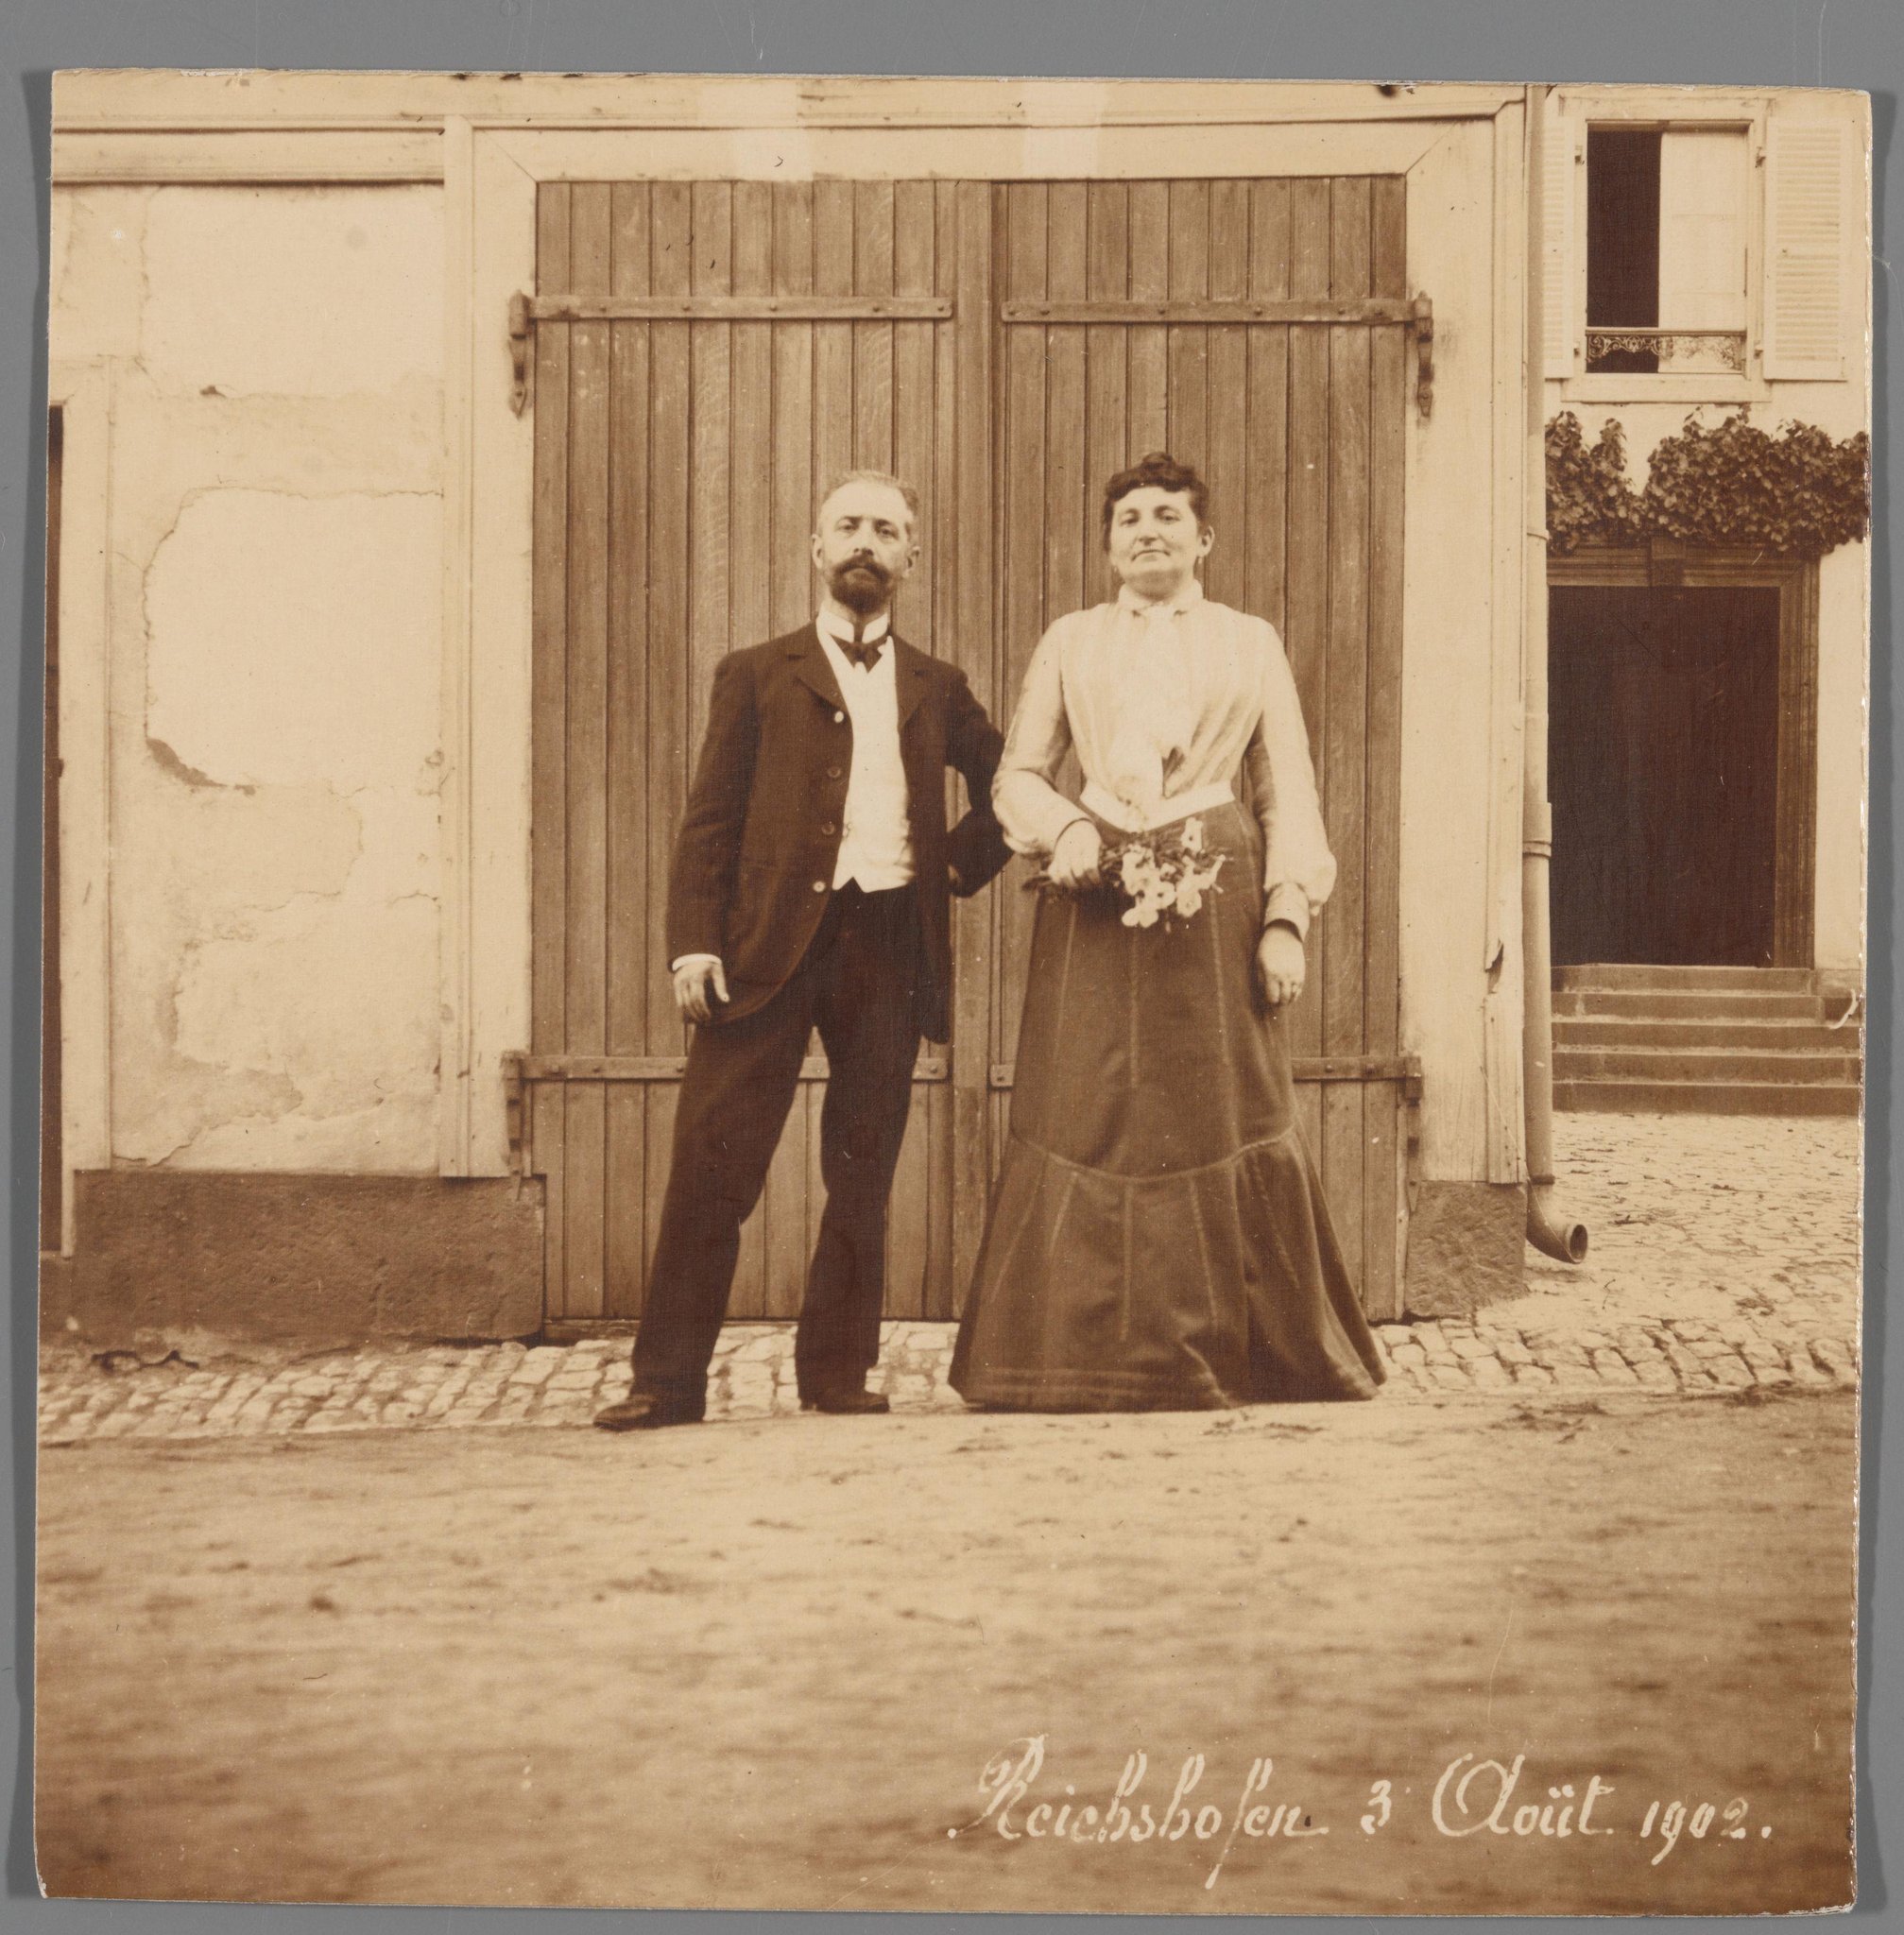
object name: photograph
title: Portraits of the Inhabitants of the Villages of Reichshoffen, Niederbronn, and Jaegerthal, Alsace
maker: Anonymous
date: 1902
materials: paper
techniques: gelatin silver print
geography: france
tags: public road in village (+ city(-scape) with figures, staffage), france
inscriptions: annotation: ‘Reichshofen [sic] 3 Août 1902’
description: Een man en vrouw (echtpaar) staand voor een huis, Reichshoffen (Bas-Rhin), Frankrijk.